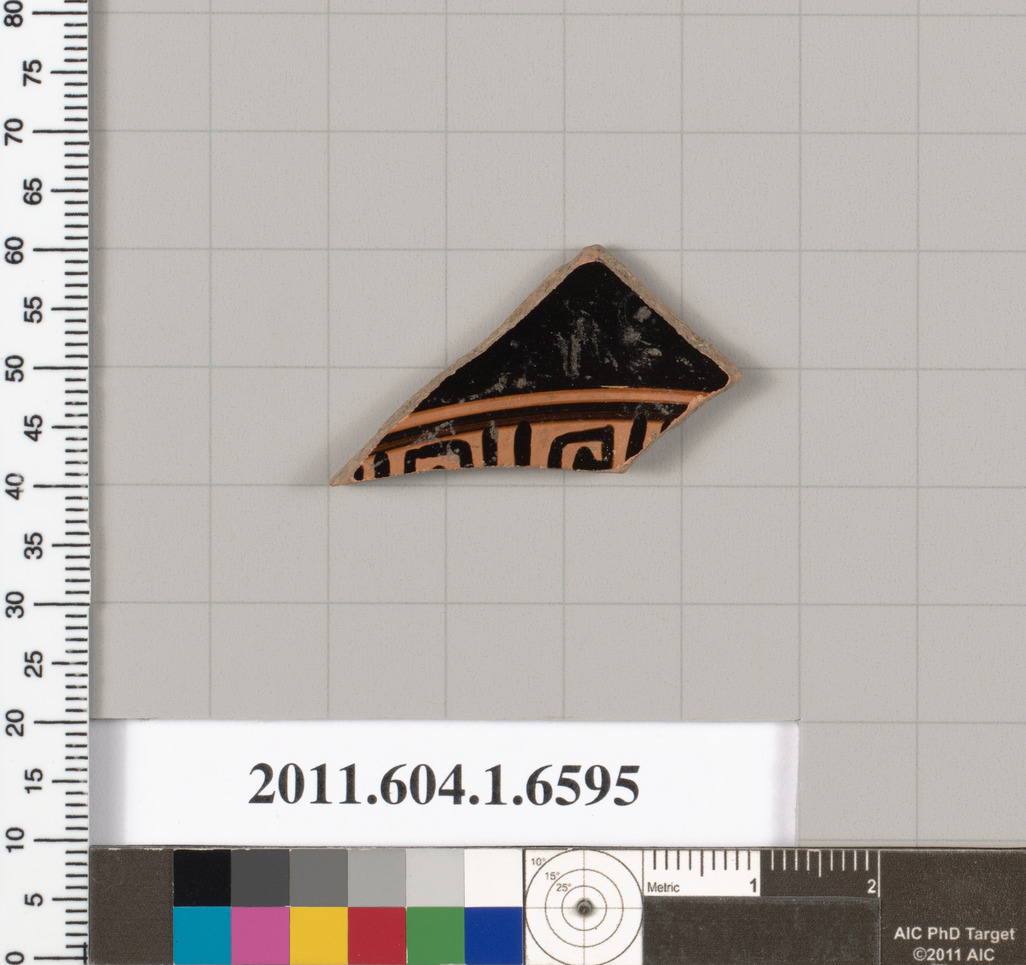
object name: kylix fragment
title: Terracotta fragment of a kylix (drinking cup)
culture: greek, attic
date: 490-480 BCE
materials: terracotta